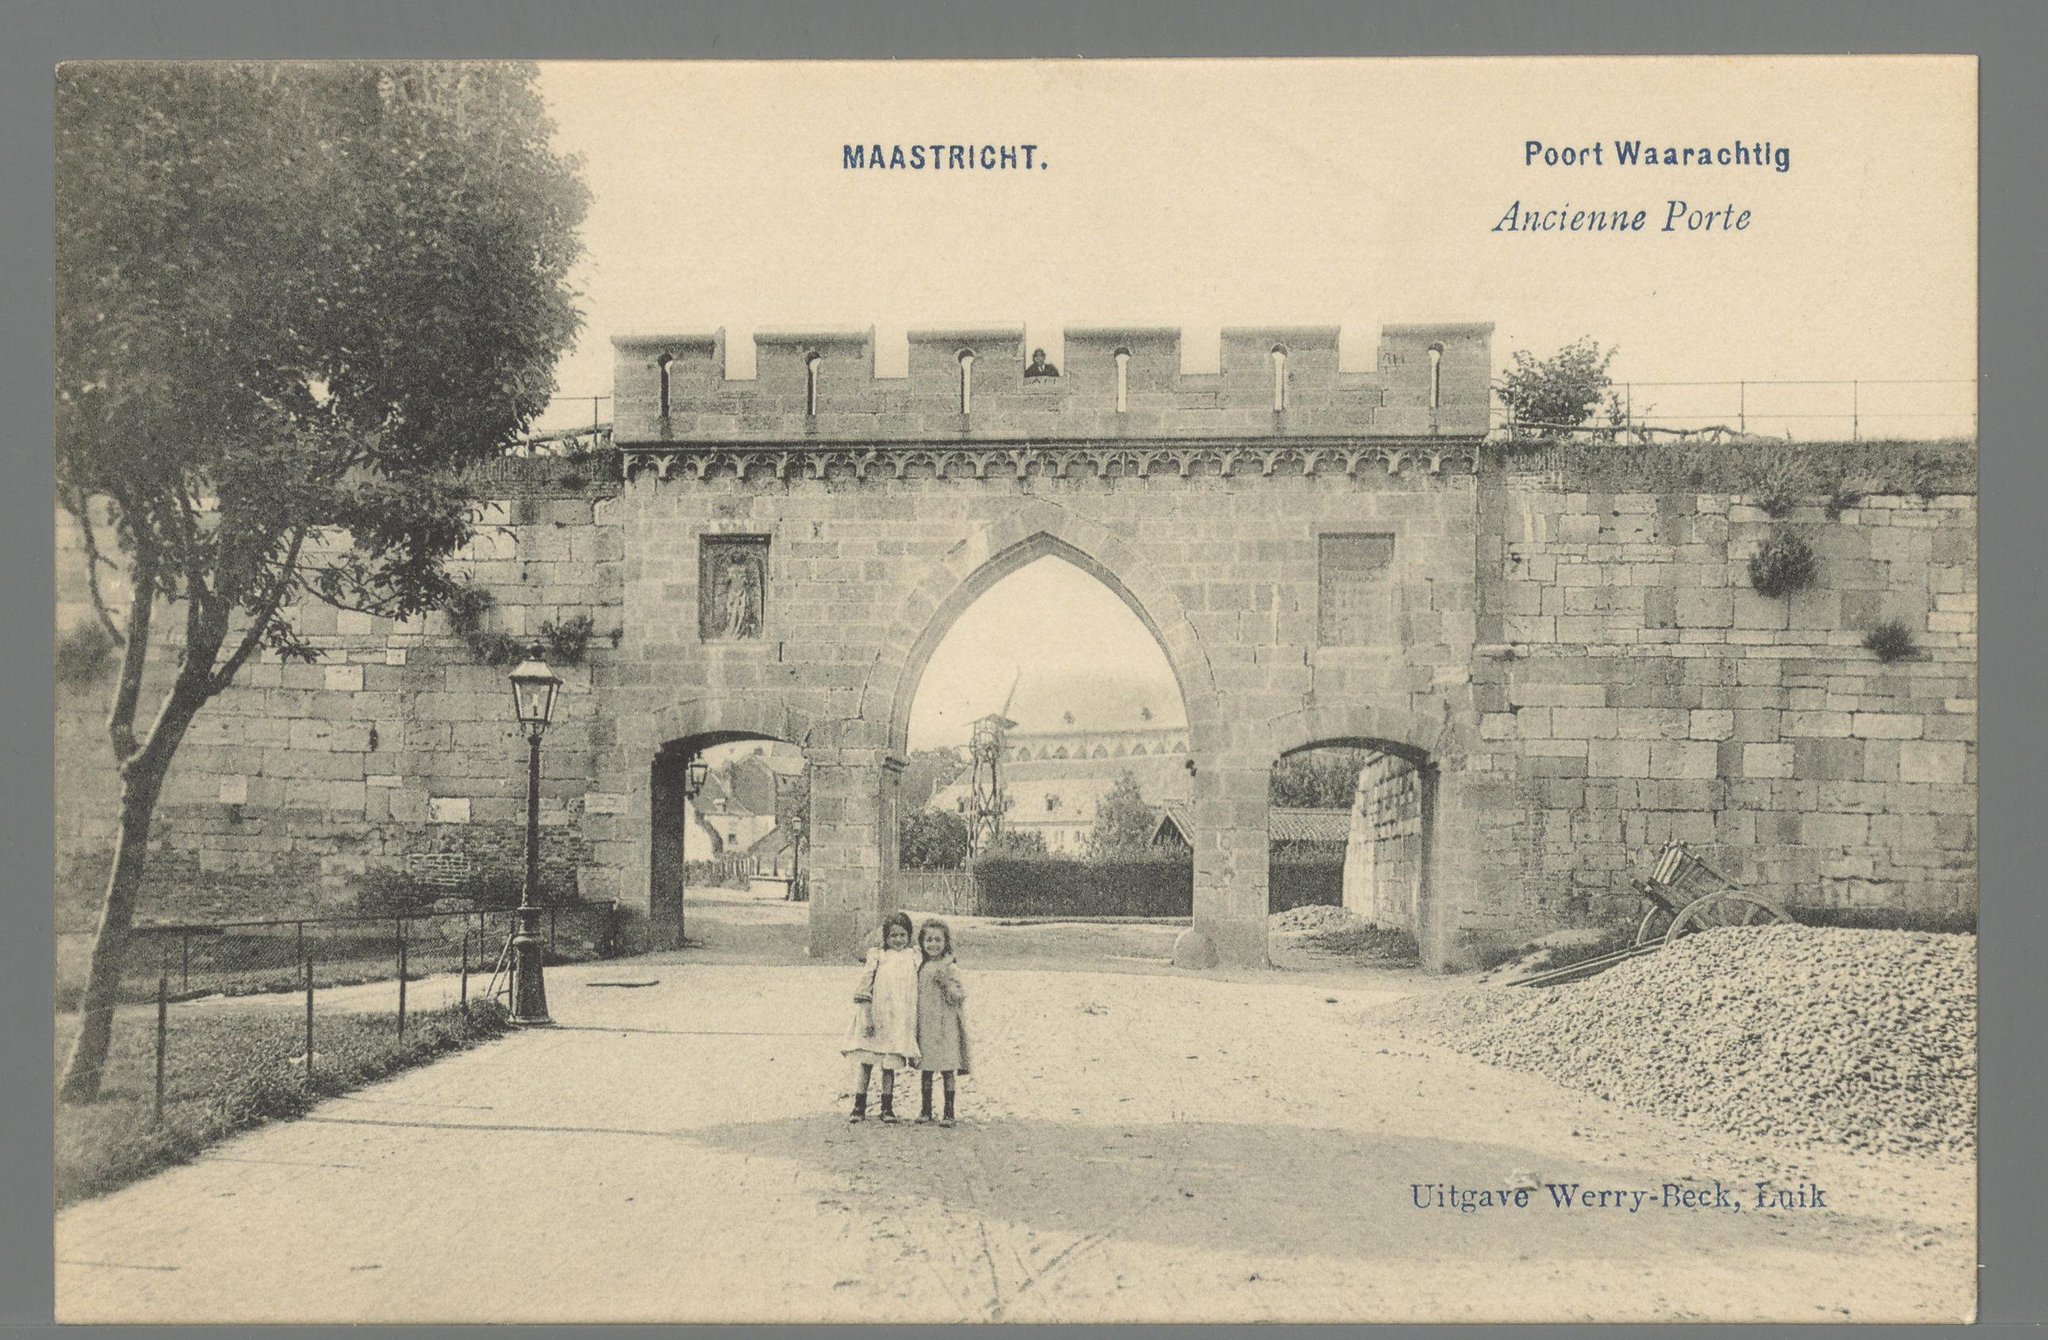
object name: ansichtkaart, prentbriefkaart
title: Maastricht. Poort Waarachtig / Ancienne Porte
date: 1905-1906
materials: cardboard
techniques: photograph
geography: maastricht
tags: city-walls, city-gate